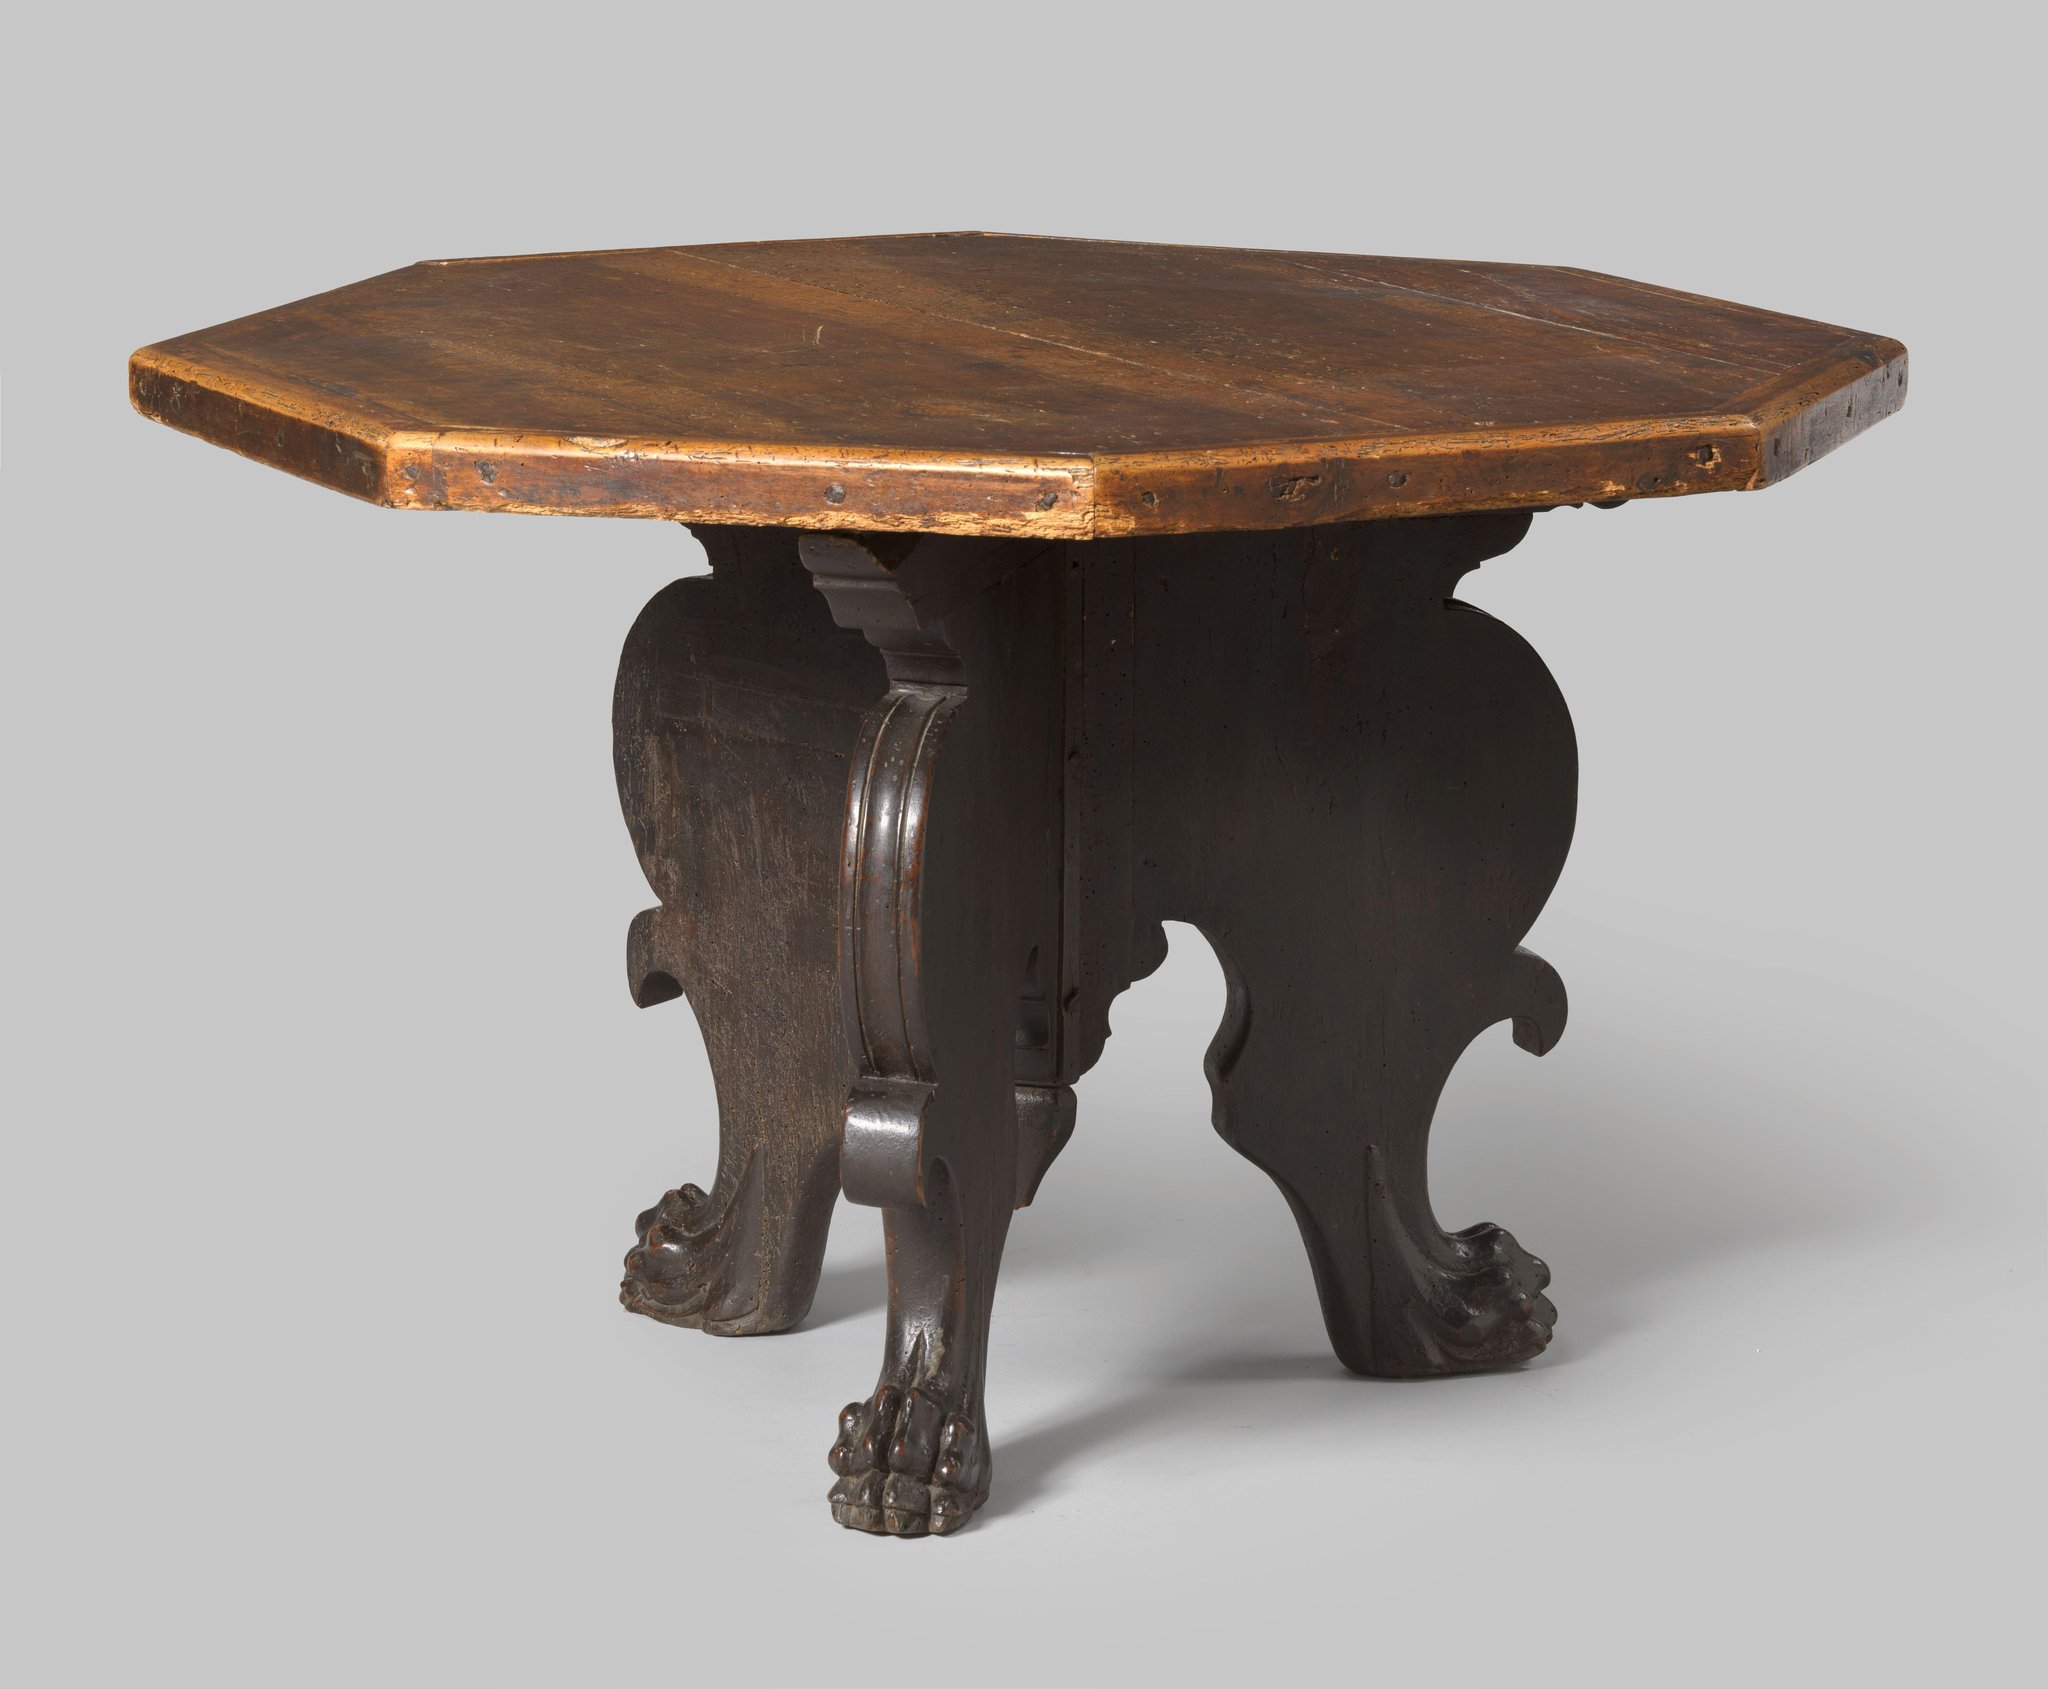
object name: table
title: Tafel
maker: Anonymous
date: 1500-1600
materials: wood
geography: tuscany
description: Tafel van notenhout met achthoekig blad op drie platte uitgezaagde wangen, die ten opzichte van de middenstijl straalsgewijze geplaatst zijn en paarsgewijze een hoek van 120 graden vormen. De wangen dragen geprofileerde regels, zijn aan de voorkanten S-vormig en eindigen in leeuwenklauwen met voluten. De middenstijl eindigt in een druiper.